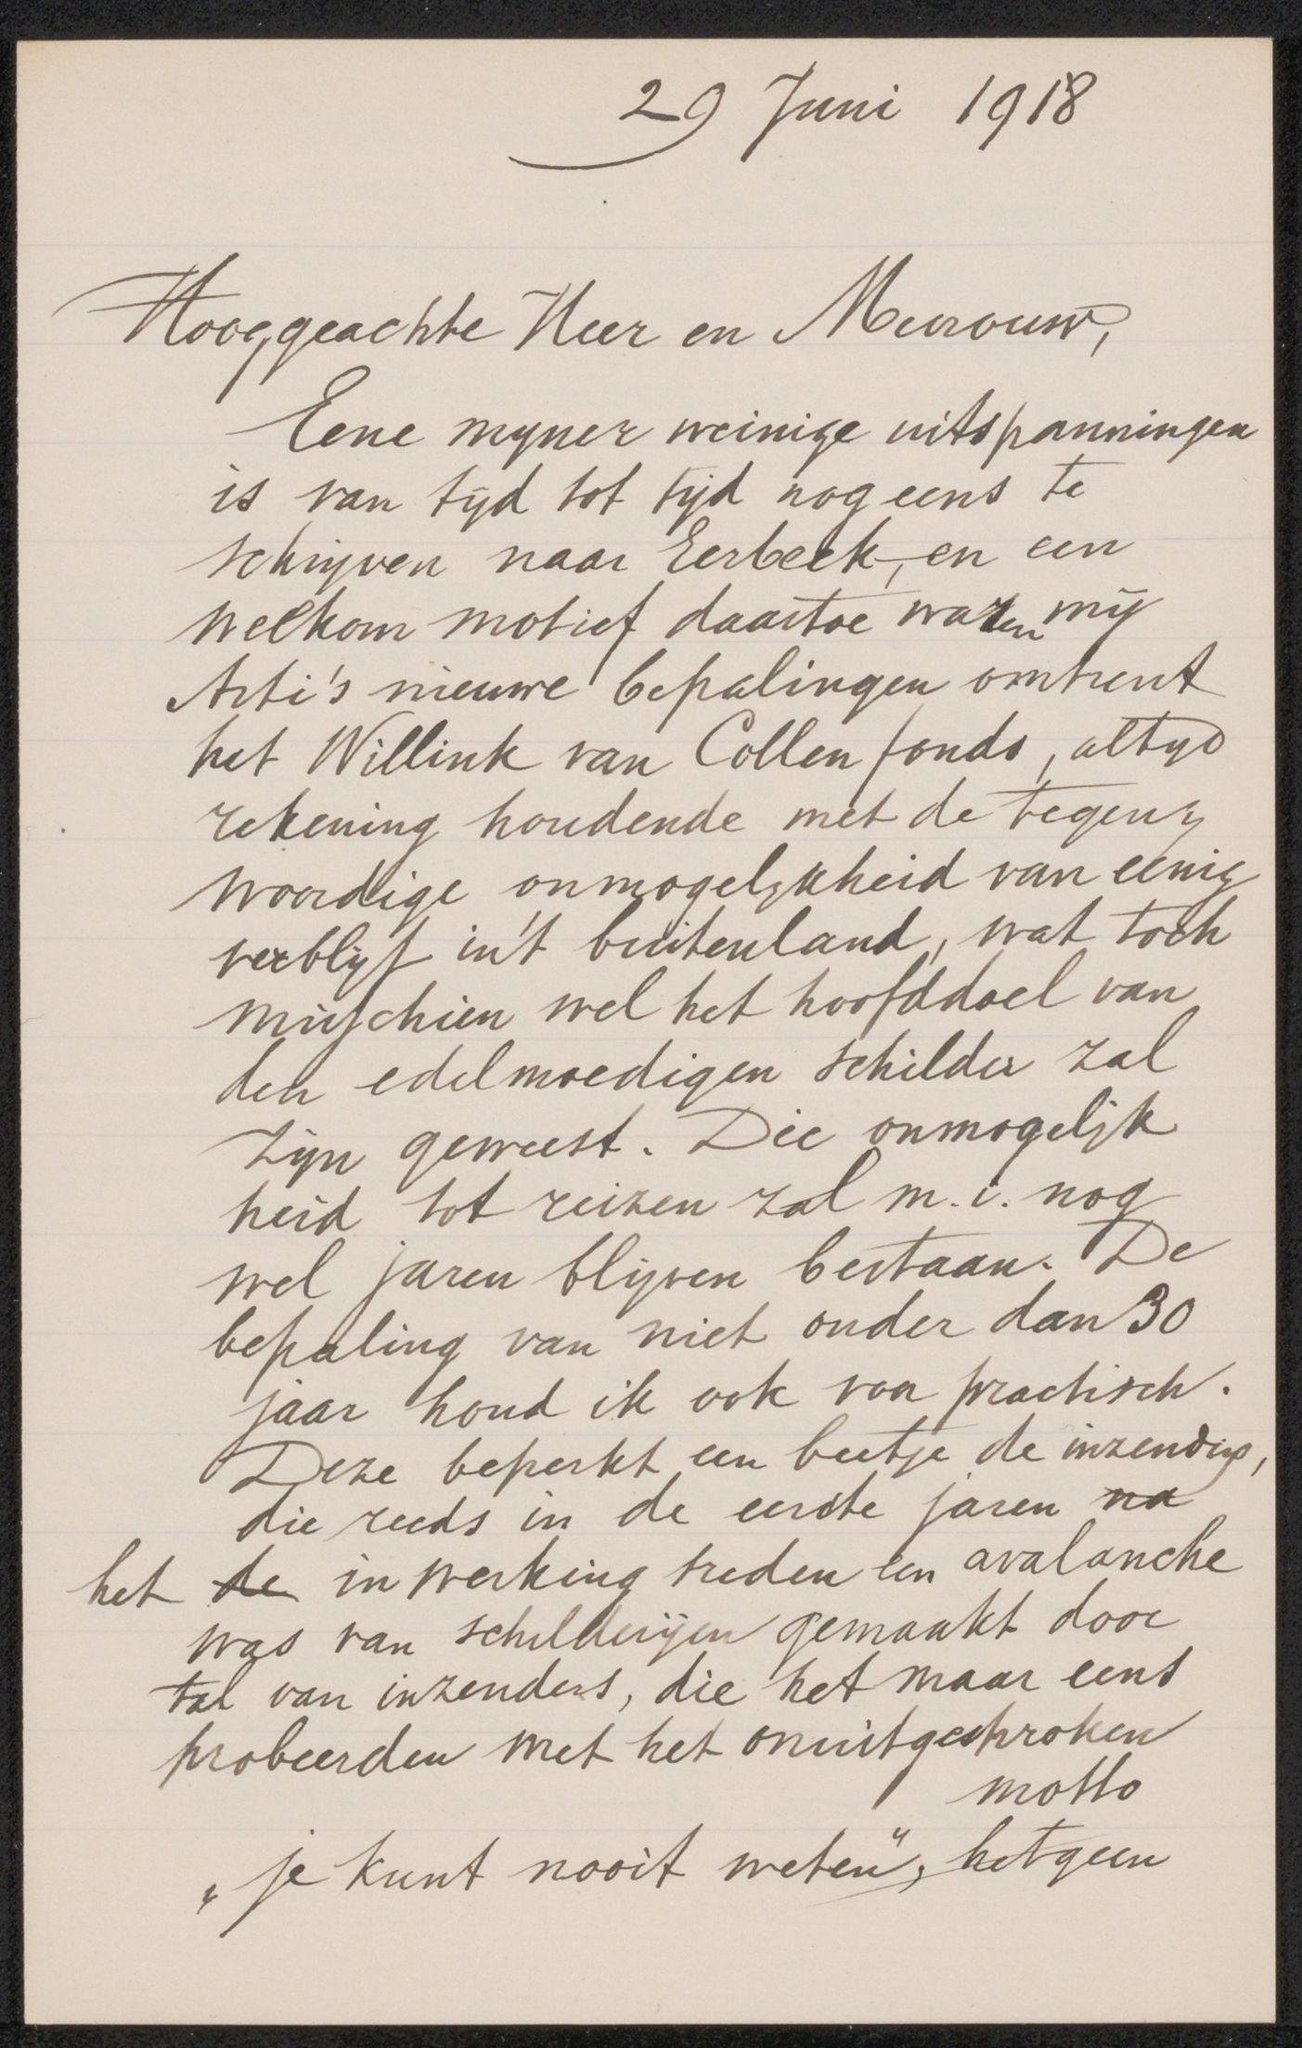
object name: letter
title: Brief aan Max Wilhelm Carl Weber en Anne Antoinette Weber-Van Bosse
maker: august allebé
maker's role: draughtsman, print maker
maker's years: 1838-1927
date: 1918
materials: ink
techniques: pen, writing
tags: batavia, amsterdam, anne antoinette weber-van bosse, wilhelm ferdinand willink van collen, painting (including book-illumination, miniature-painting)